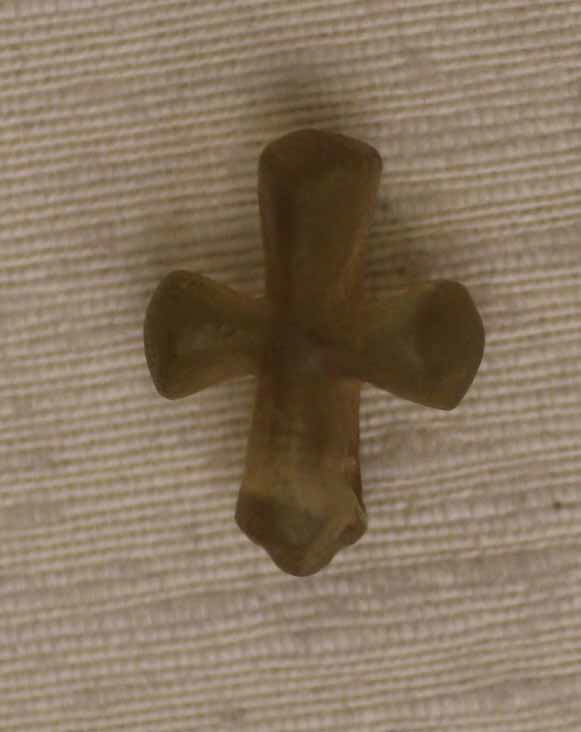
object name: cross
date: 201-1200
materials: glass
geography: egypt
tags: cross